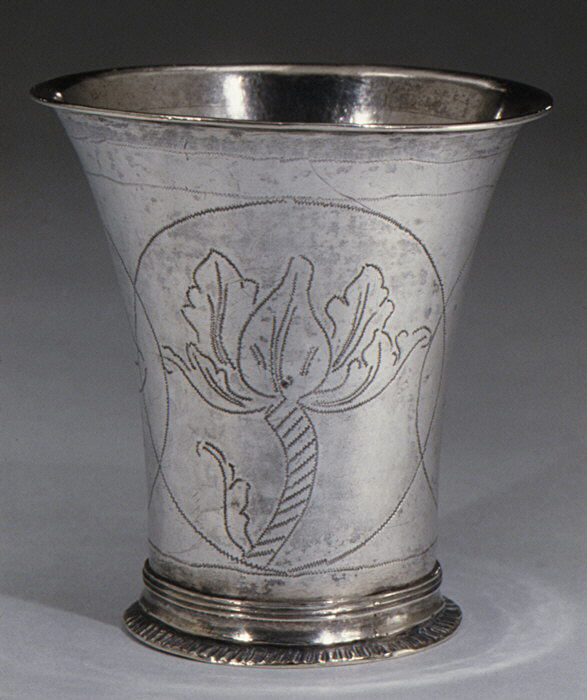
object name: beaker or cup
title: Cup or beaker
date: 1748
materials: silver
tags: flowers